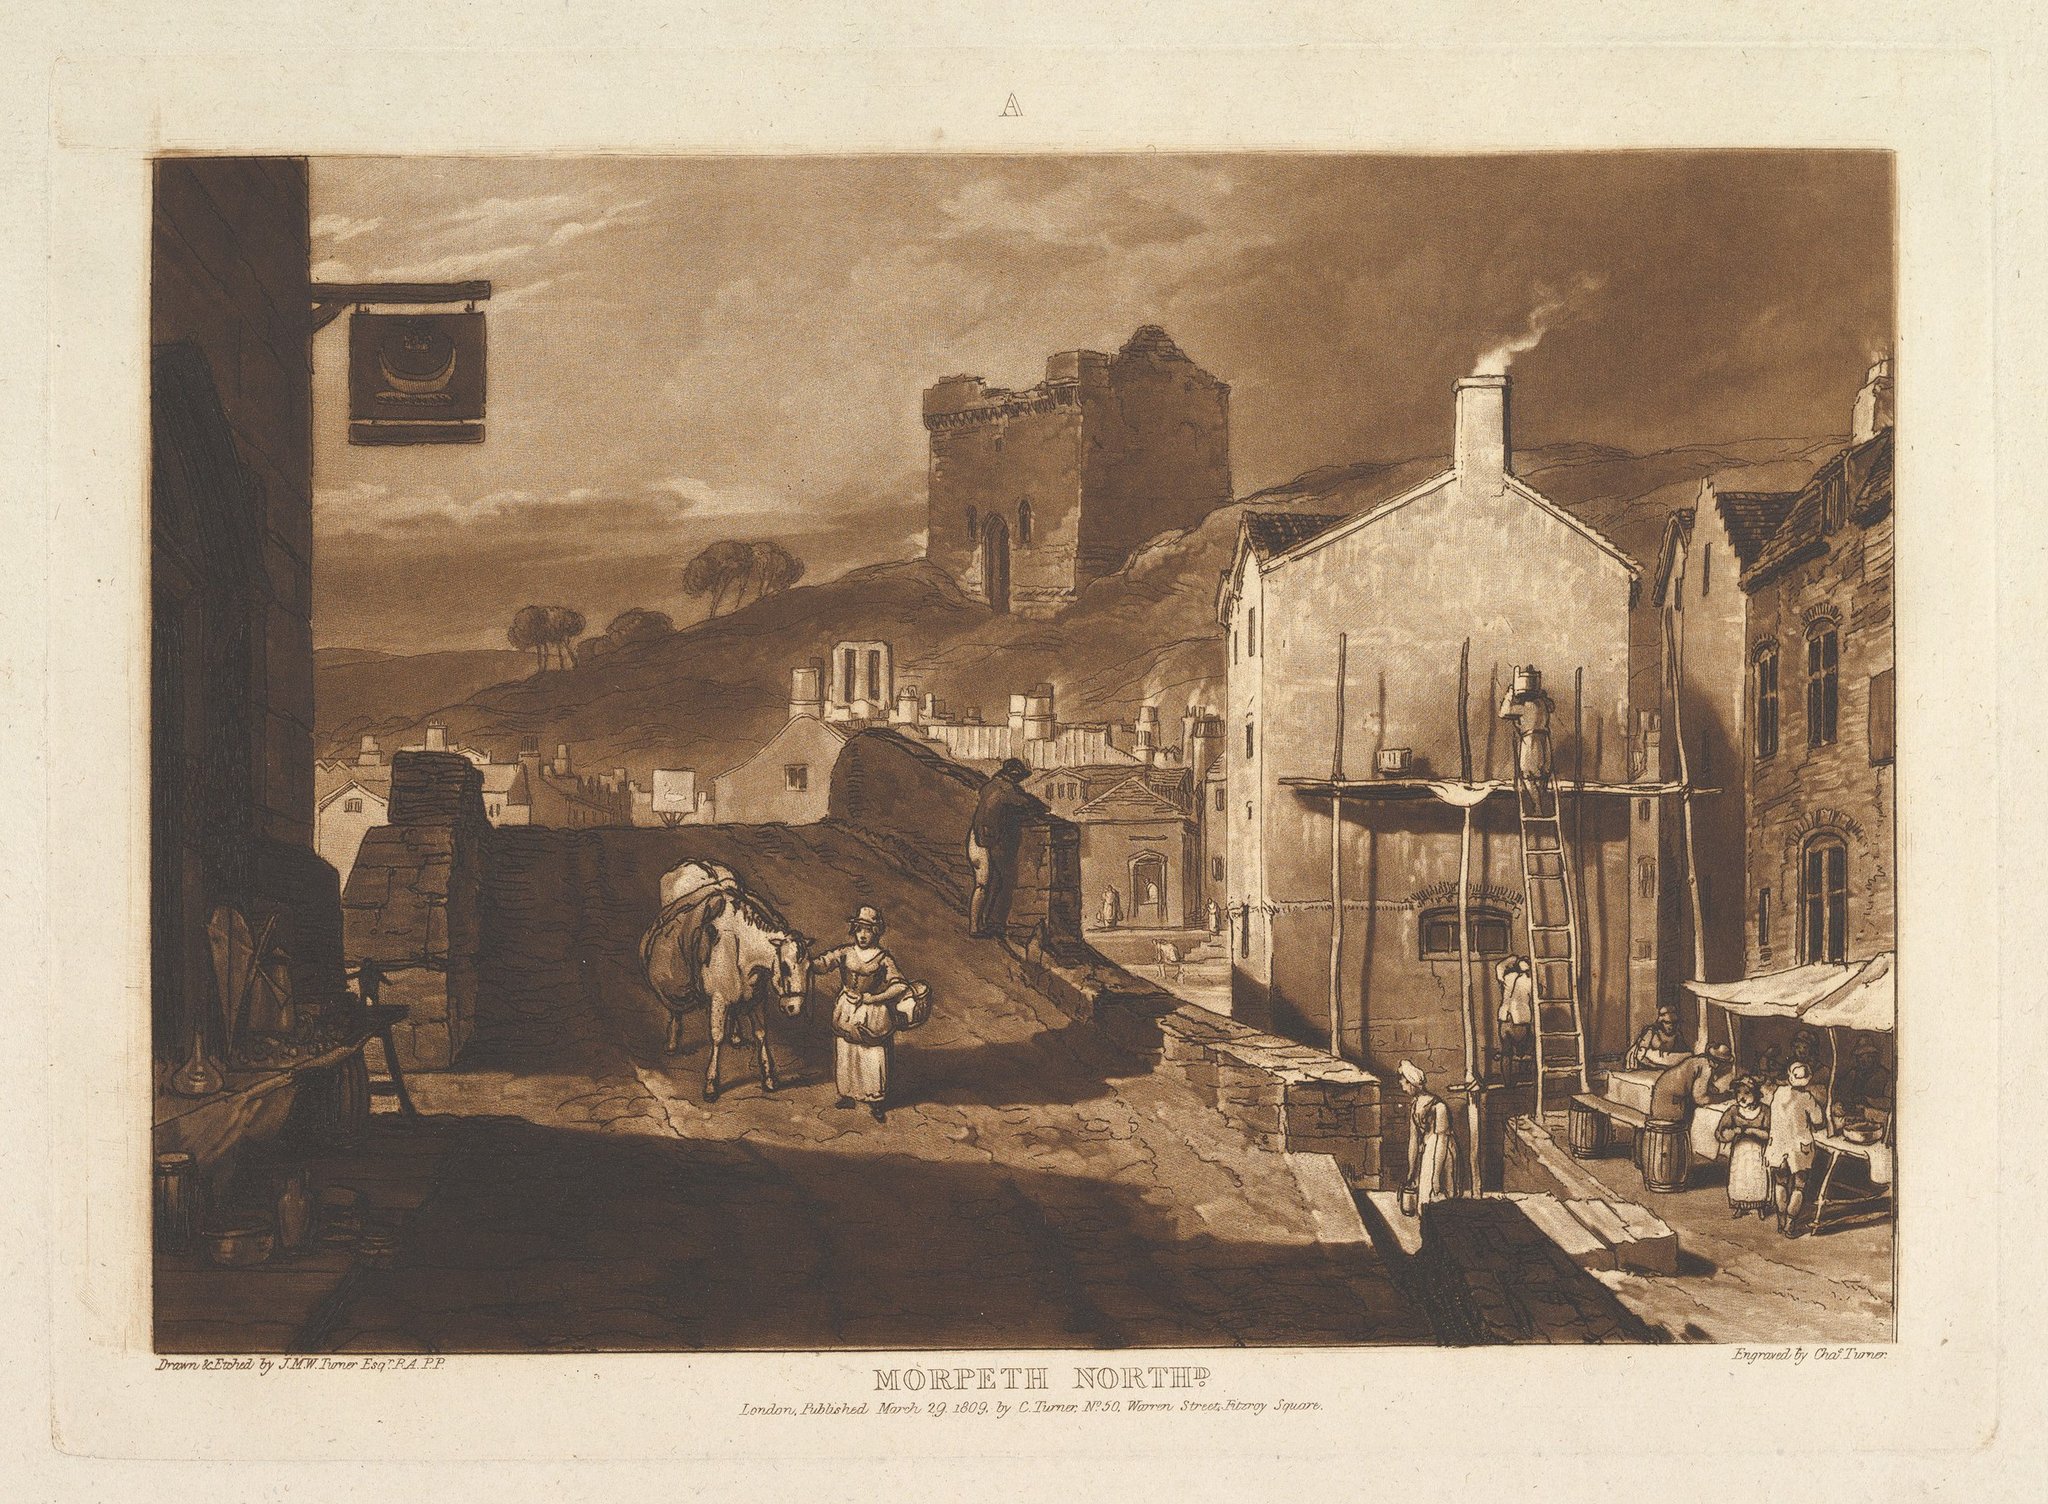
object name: print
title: Morpeth North, part IV, plate 21 from "Liber Studiorum"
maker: joseph mallord william turner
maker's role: artist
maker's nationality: british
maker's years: 1775-1851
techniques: etching, mezzotint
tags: towns,men,women,horses